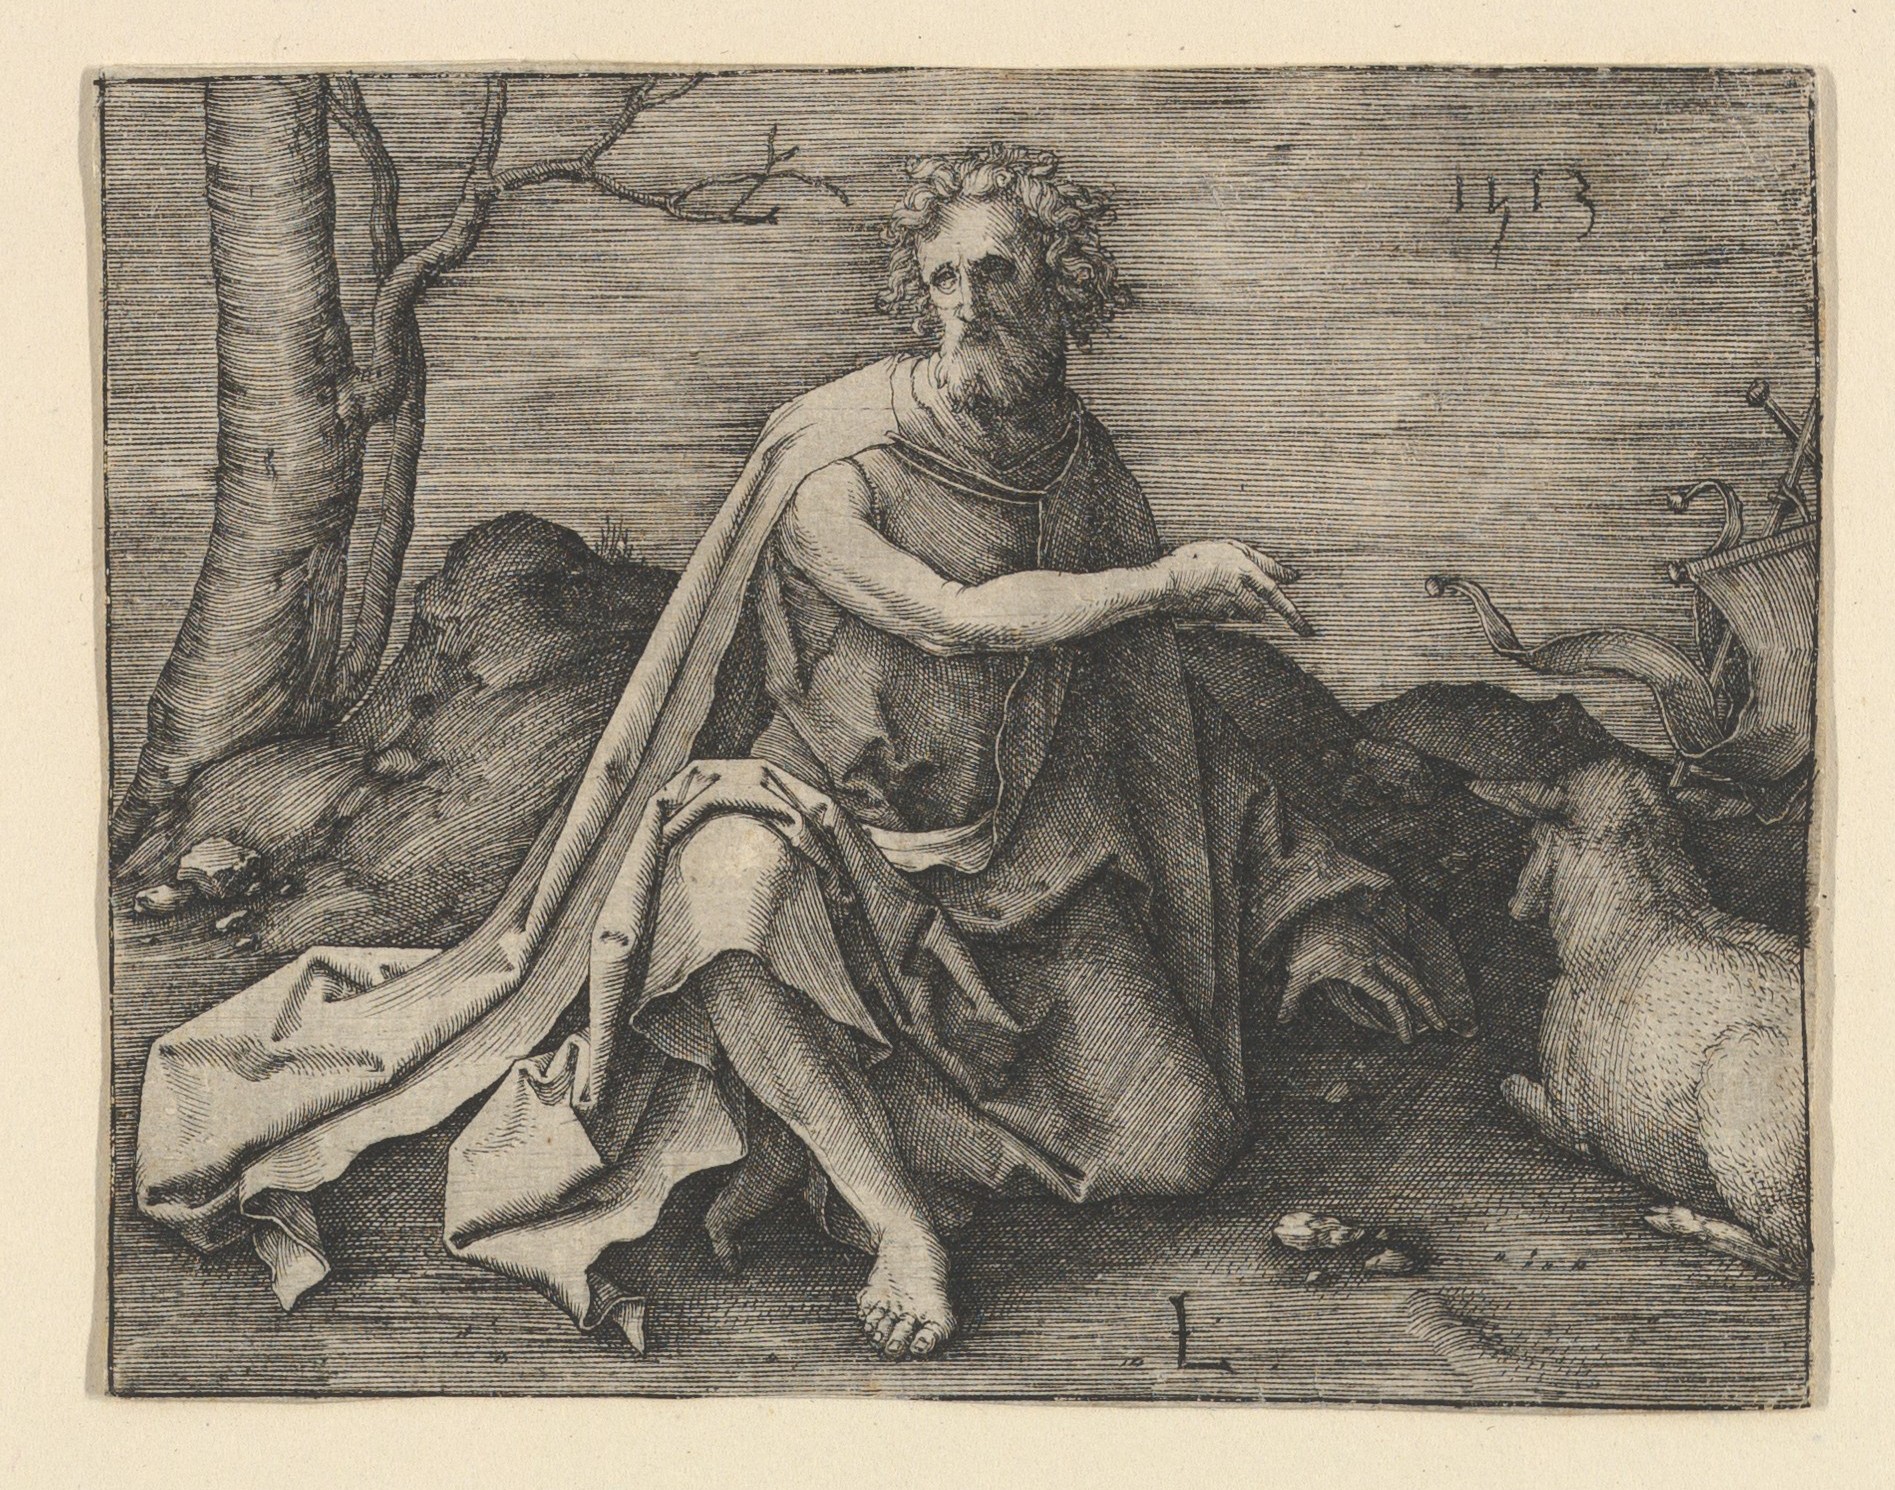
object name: print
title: St. John the Baptist in the Desert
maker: lucas van leyden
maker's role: artist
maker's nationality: netherlandish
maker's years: 1494-1533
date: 1513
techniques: engraving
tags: deserts,saint john the baptist